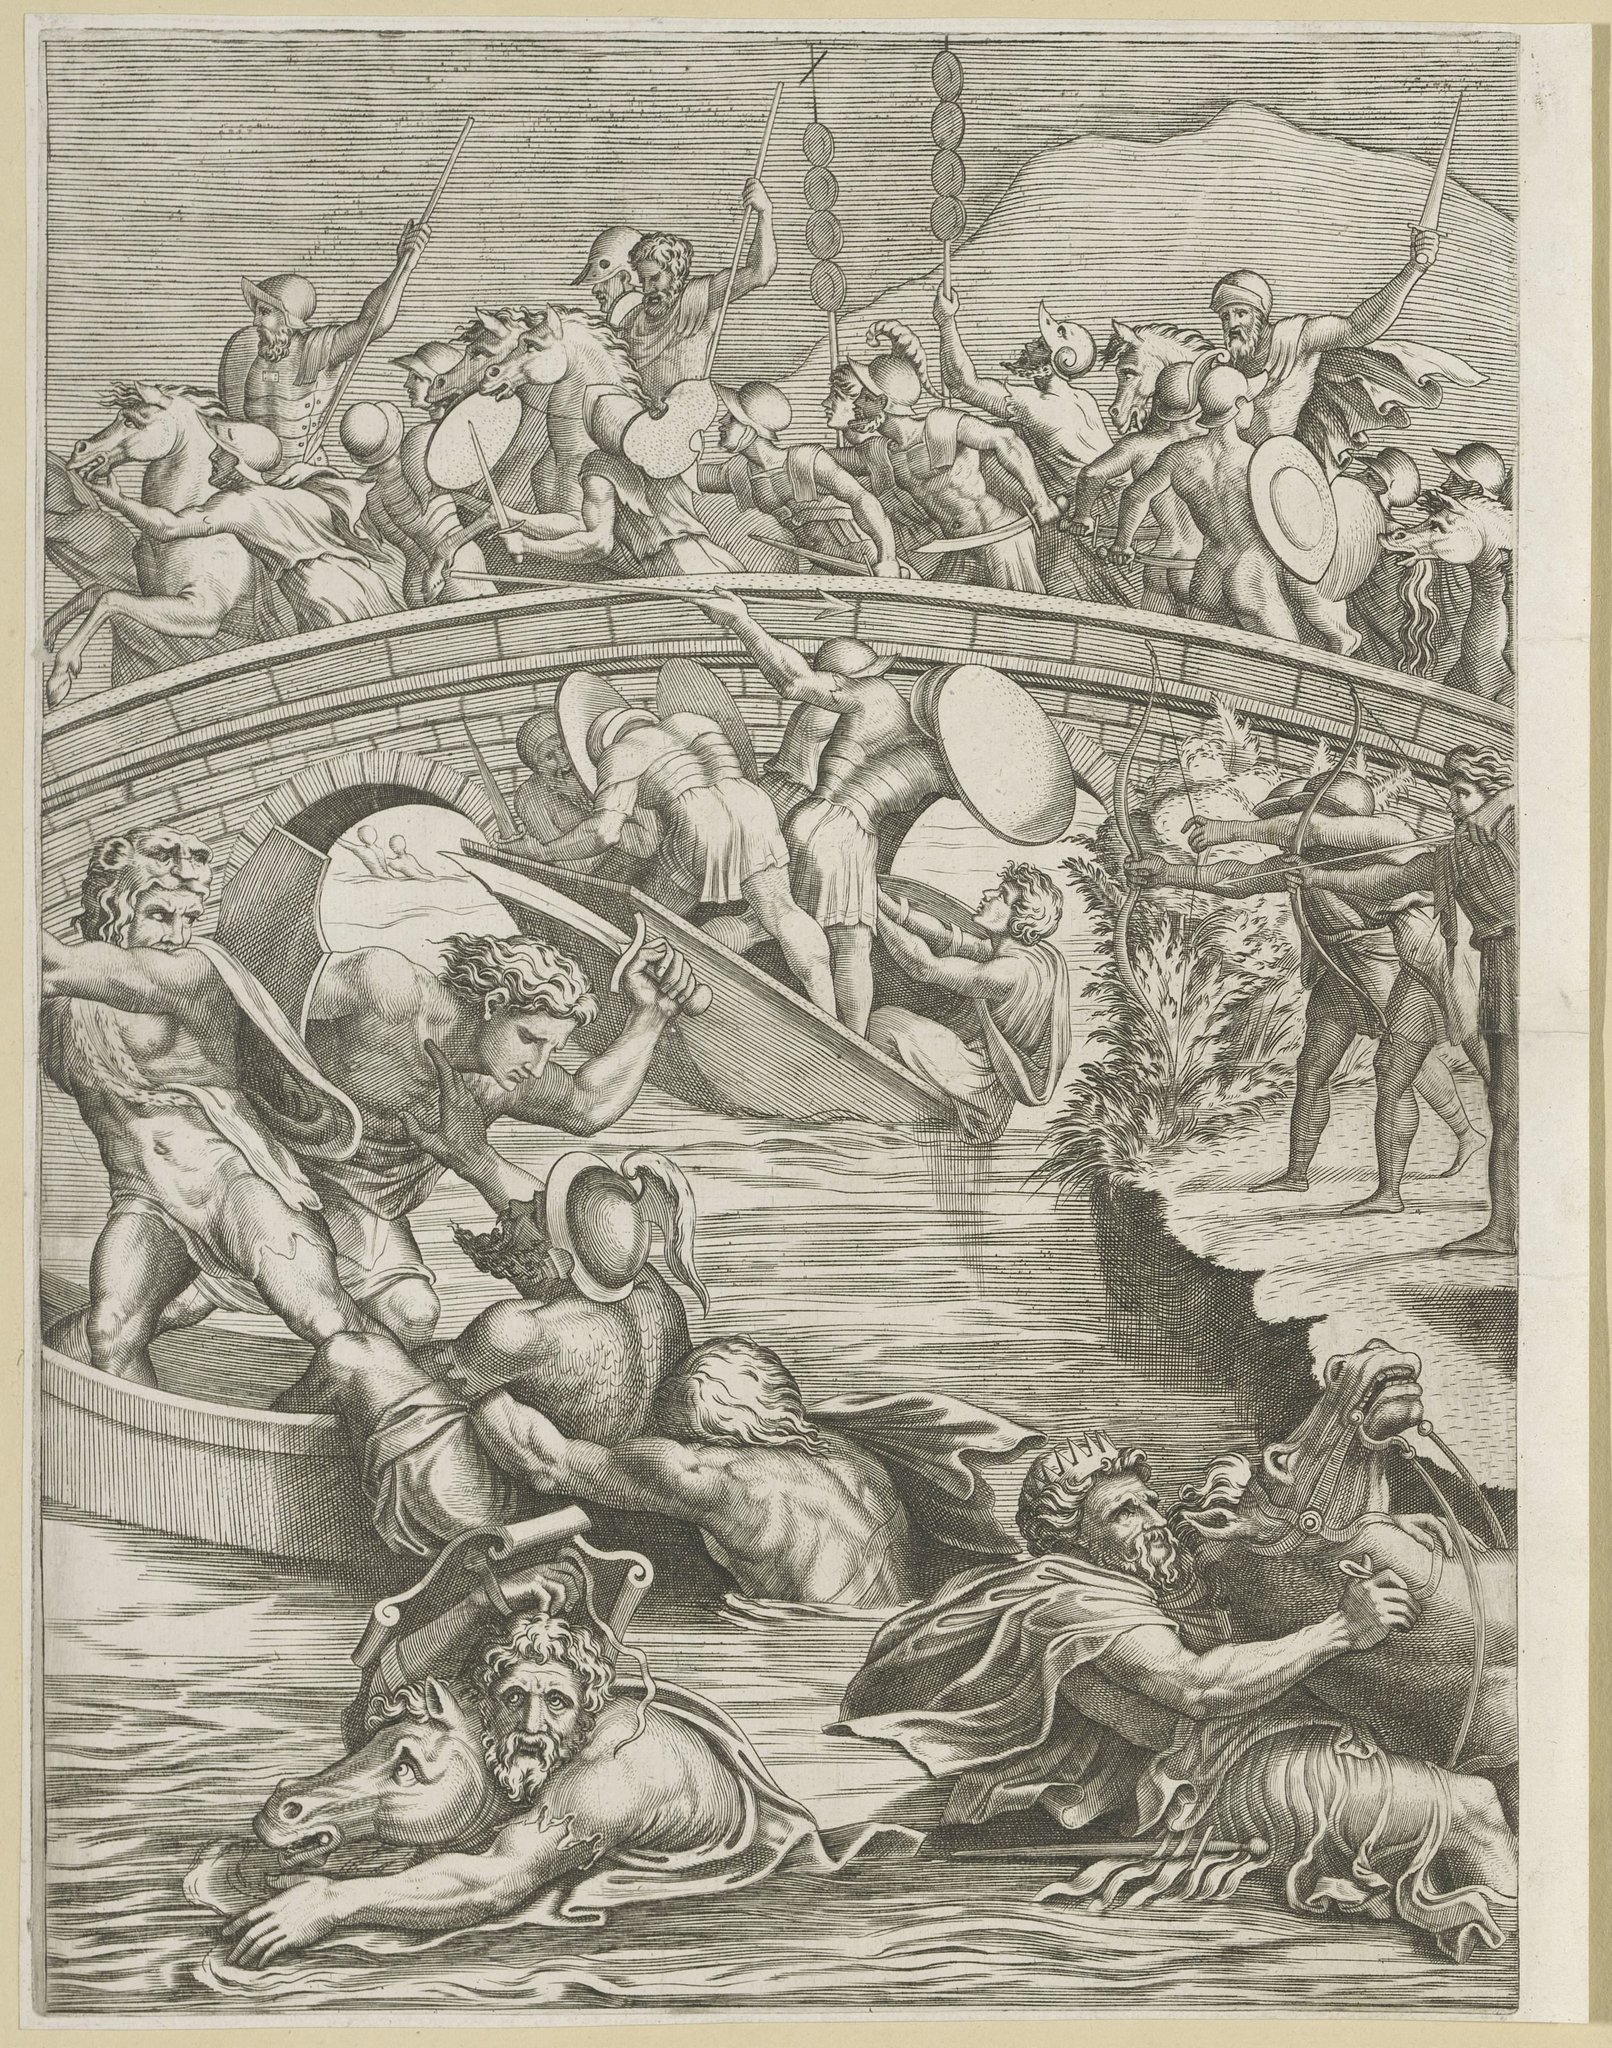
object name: print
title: Slag bij de Milvische brug (linker blad)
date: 1500-1599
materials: paper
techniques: engraving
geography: vatican city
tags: the battle of the milvian bridge (saxa rubra): st. constantine on horseback confronts maxentius; a cross appears in the sky with in fiery letters 'in hoc signo vinces' (the raised standards of the roman soldiers carry a cross or the chi-rho monogram), warfare; military affairs (+ cavalry, horsemen), the soldier; the soldier's life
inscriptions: collector's mark: Lugt 10, collector's mark: Lugt 11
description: Gevechtsscène in een landschap: slag bij de Milvische brug. De soldaten van Constantijn in gevecht met de soldaten van Maxentius. Dode lichamen liggen op de grond. Soldaten te paard verdrinken in de rivier.